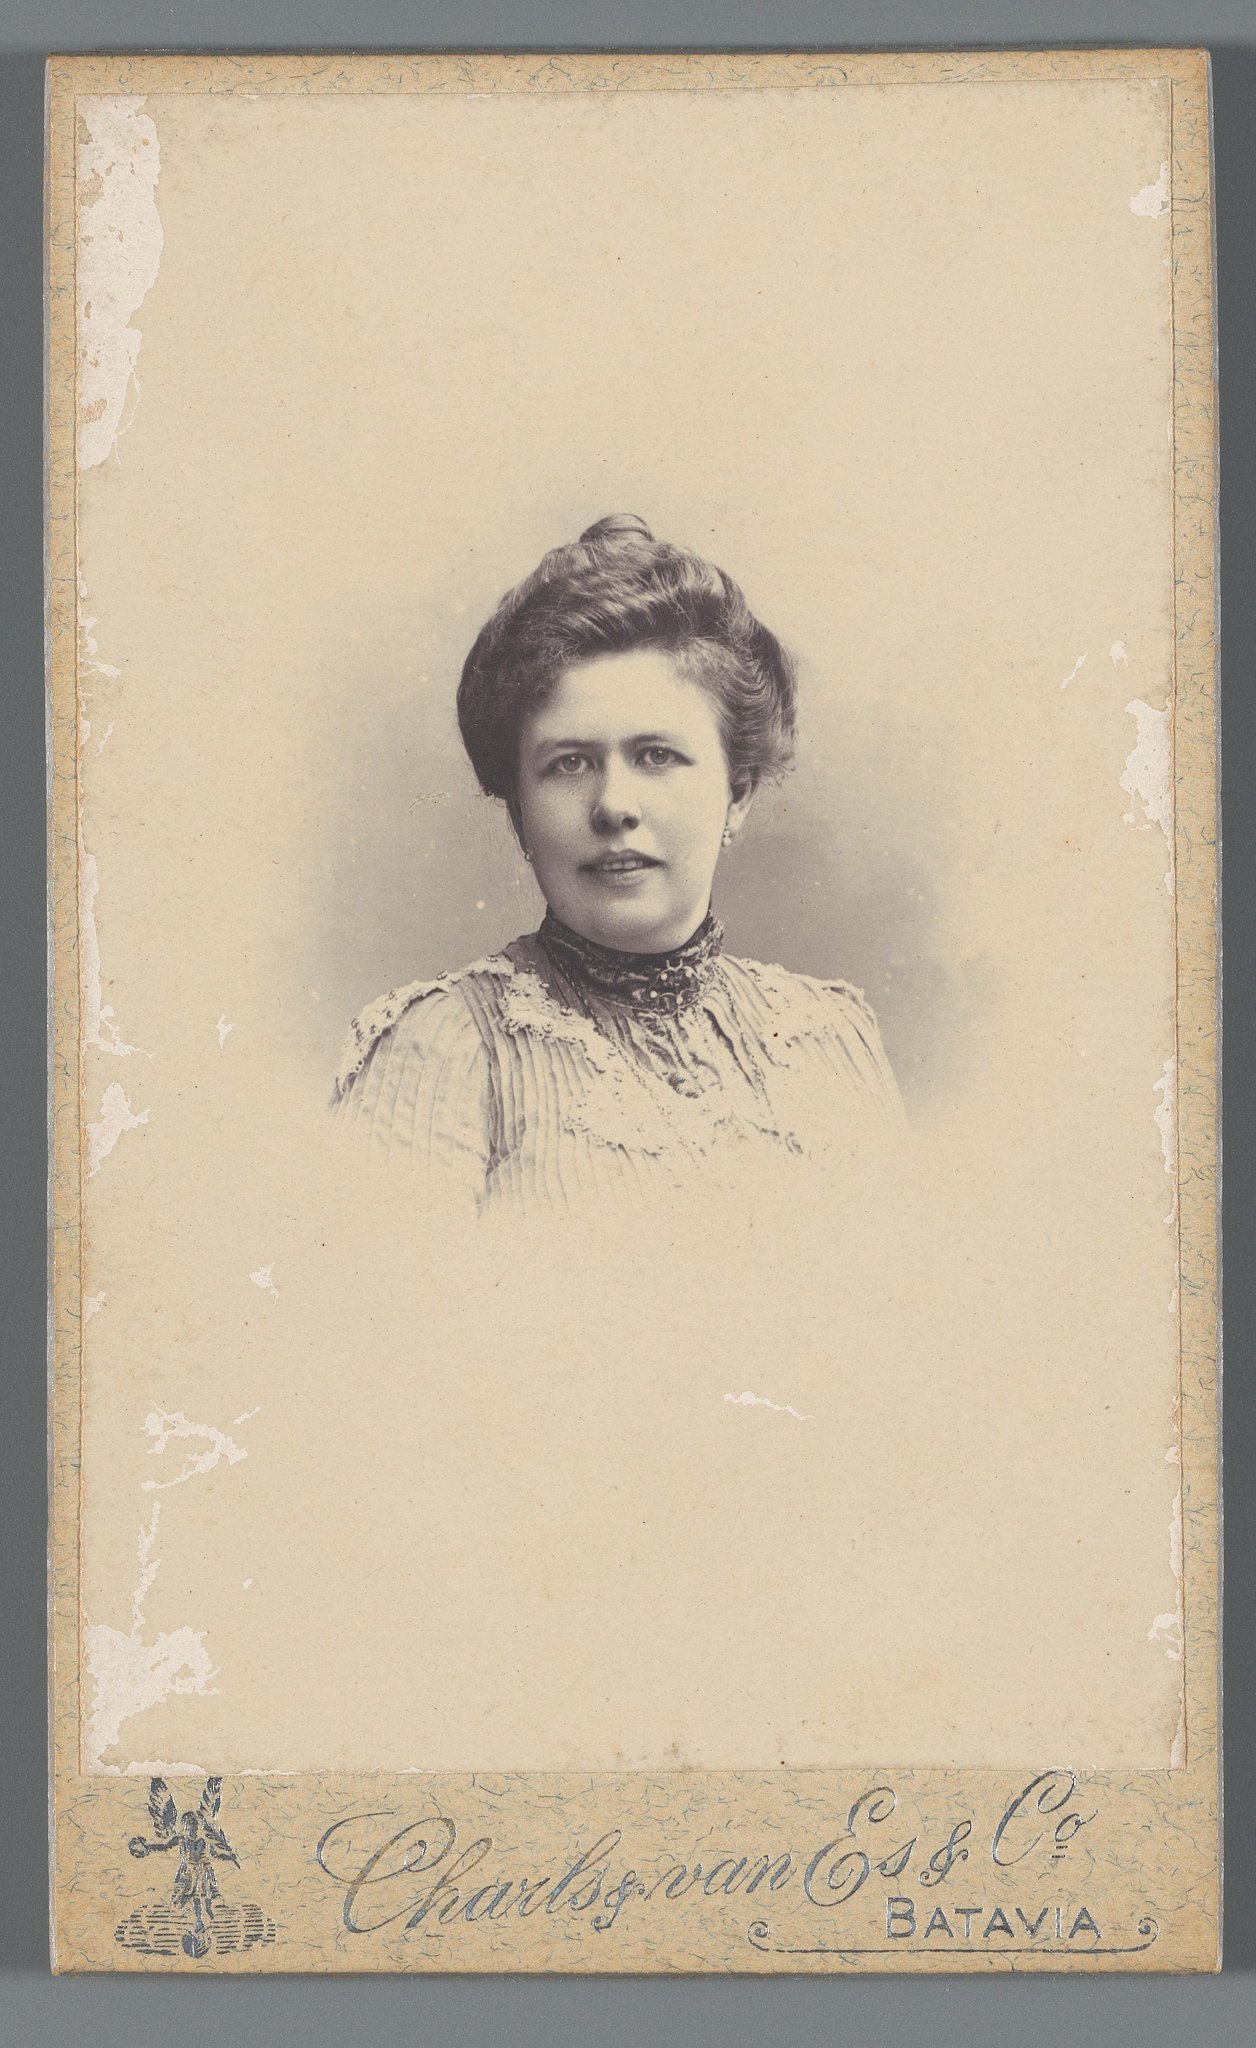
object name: carte de visite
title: Studioportret van Poppy Dunlop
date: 1890-1910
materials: cardboard, photographic support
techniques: albumen print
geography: batavia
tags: carolina johanna theofanie bernardine van den berg-dunlop (poppy)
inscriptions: name, name: ‘Poppy v. d. Berg / Dunlop’, name: ‘CHARLS & VAN ES & Co / BATAVIA’